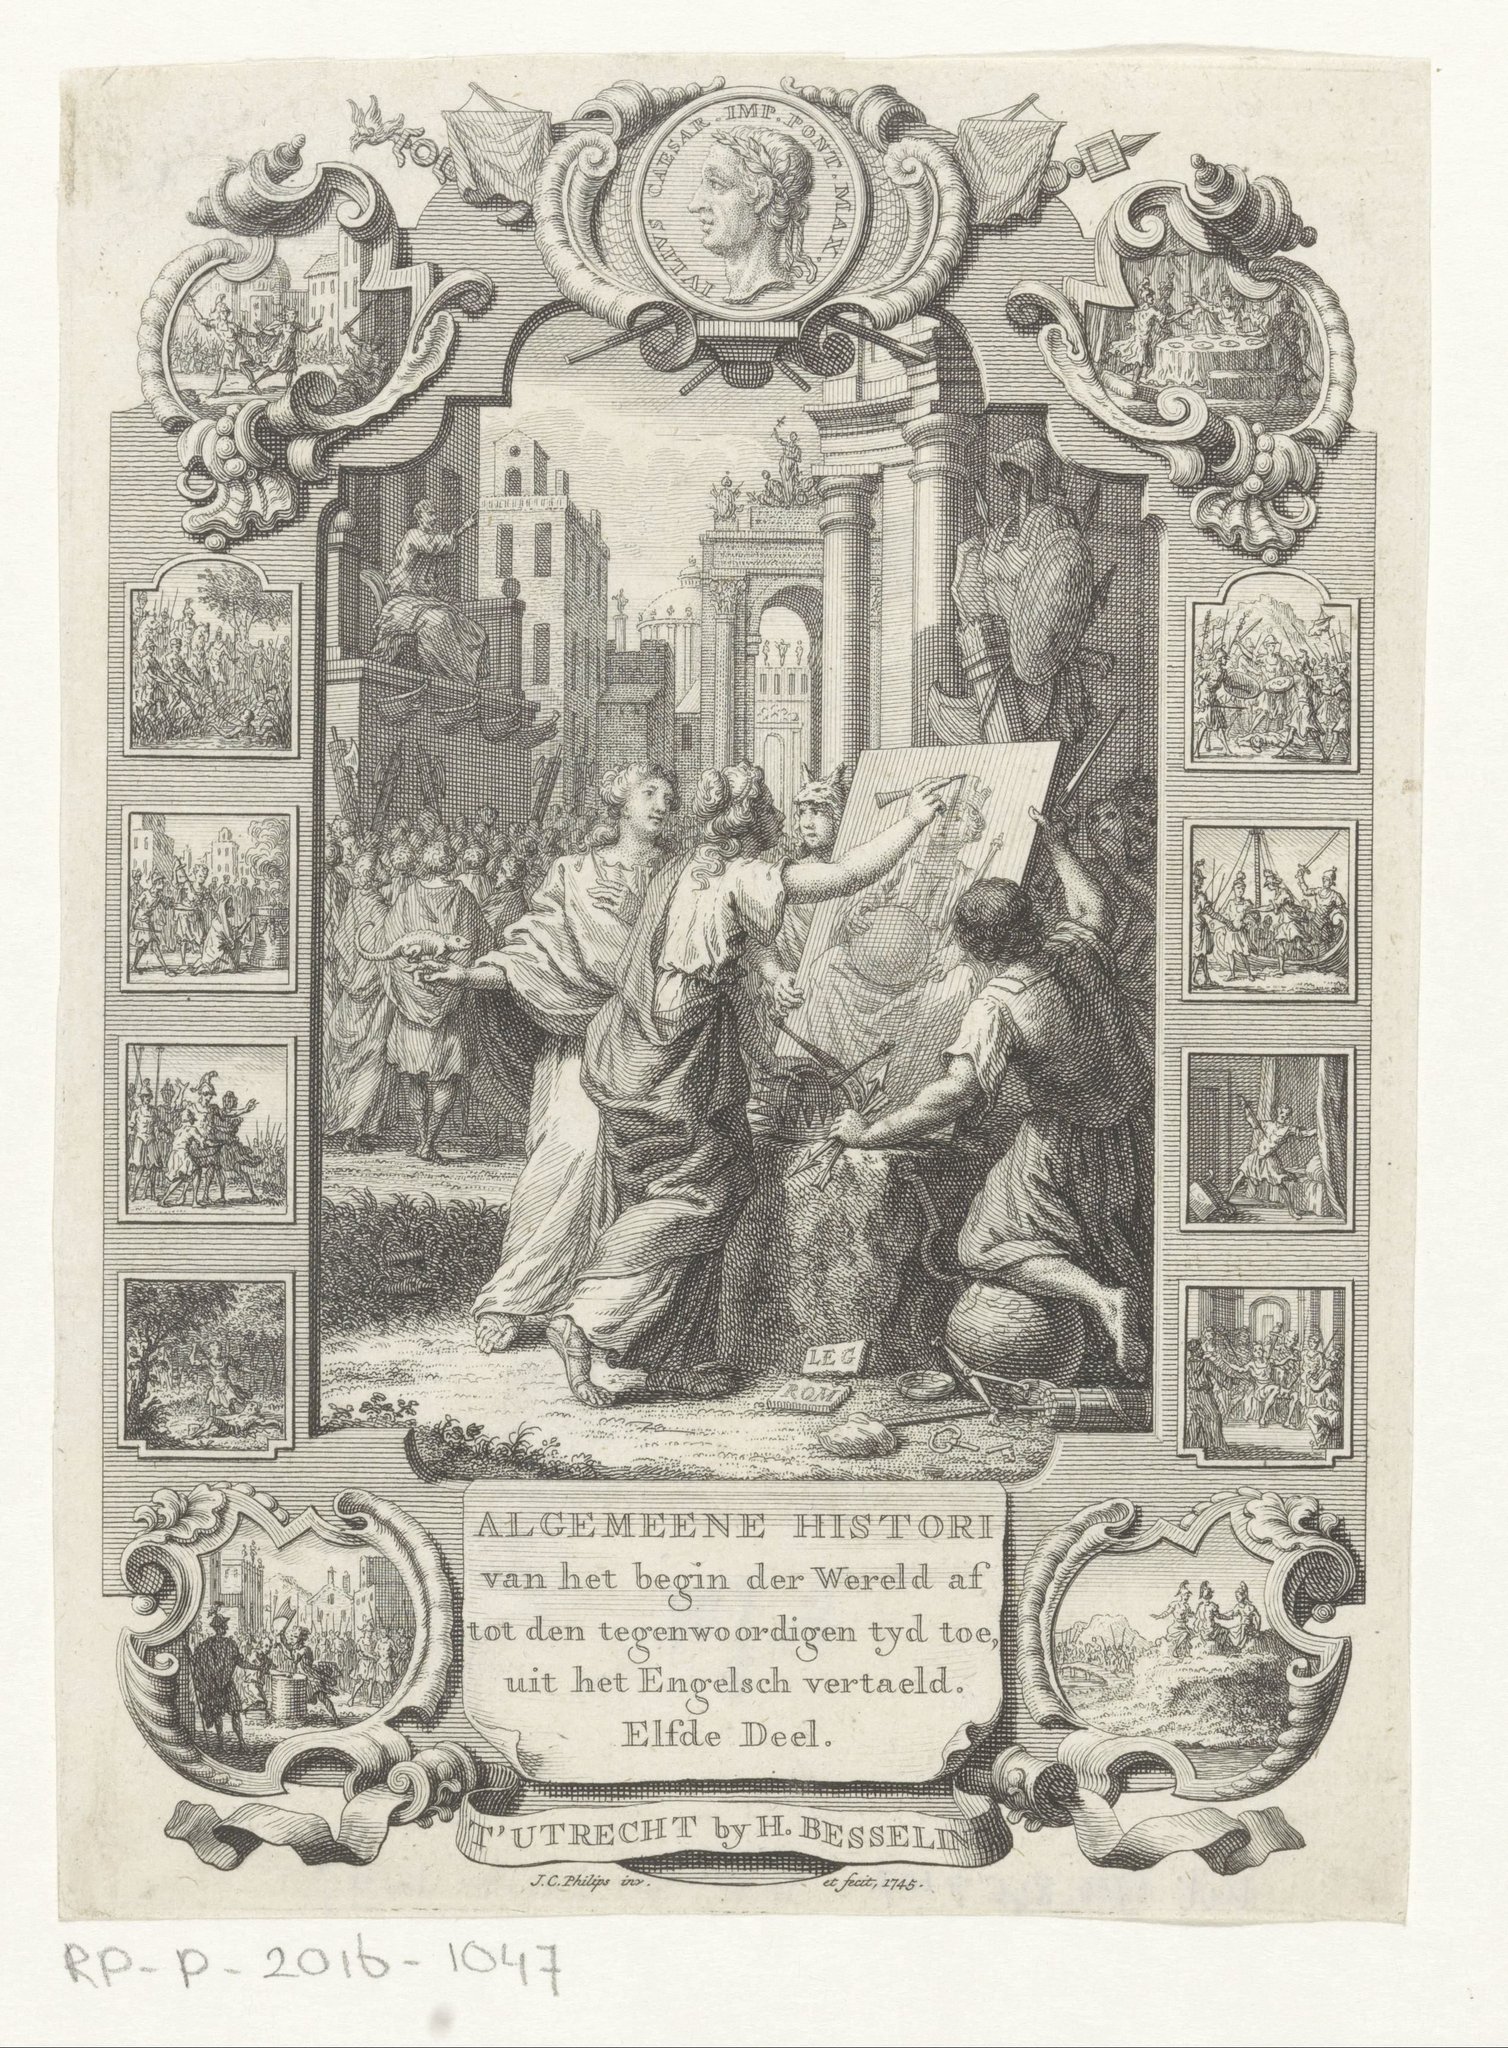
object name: print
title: Titelpagina voor: Kornelis Westerbaen, Algemeene histori, 1745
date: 1745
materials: paper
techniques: engraving, etching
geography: amsterdam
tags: crown (symbol of sovereignty), drawing, monarchy; 'monarchia mondana' (ripa)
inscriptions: collector's mark: Lugt 2228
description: Een vrouw tekent een portret van de personificatie van de monarchie, terwijl zij op een voetstuk met kronen en scepters leunt. Bij haar staat een vrouw met salamander op de hand en een figuur op de rug gezien met zijn knie op een globe en zwaard en pijlen in de hand. Achter het portret een wapentrofee. Links in de achtergrond zit een tronende figuur op een verhoging voor een menigte. In de omlijsting van de cartouche scènes die te maken hebben met de geschiedenis van het Romeinse Rijk.